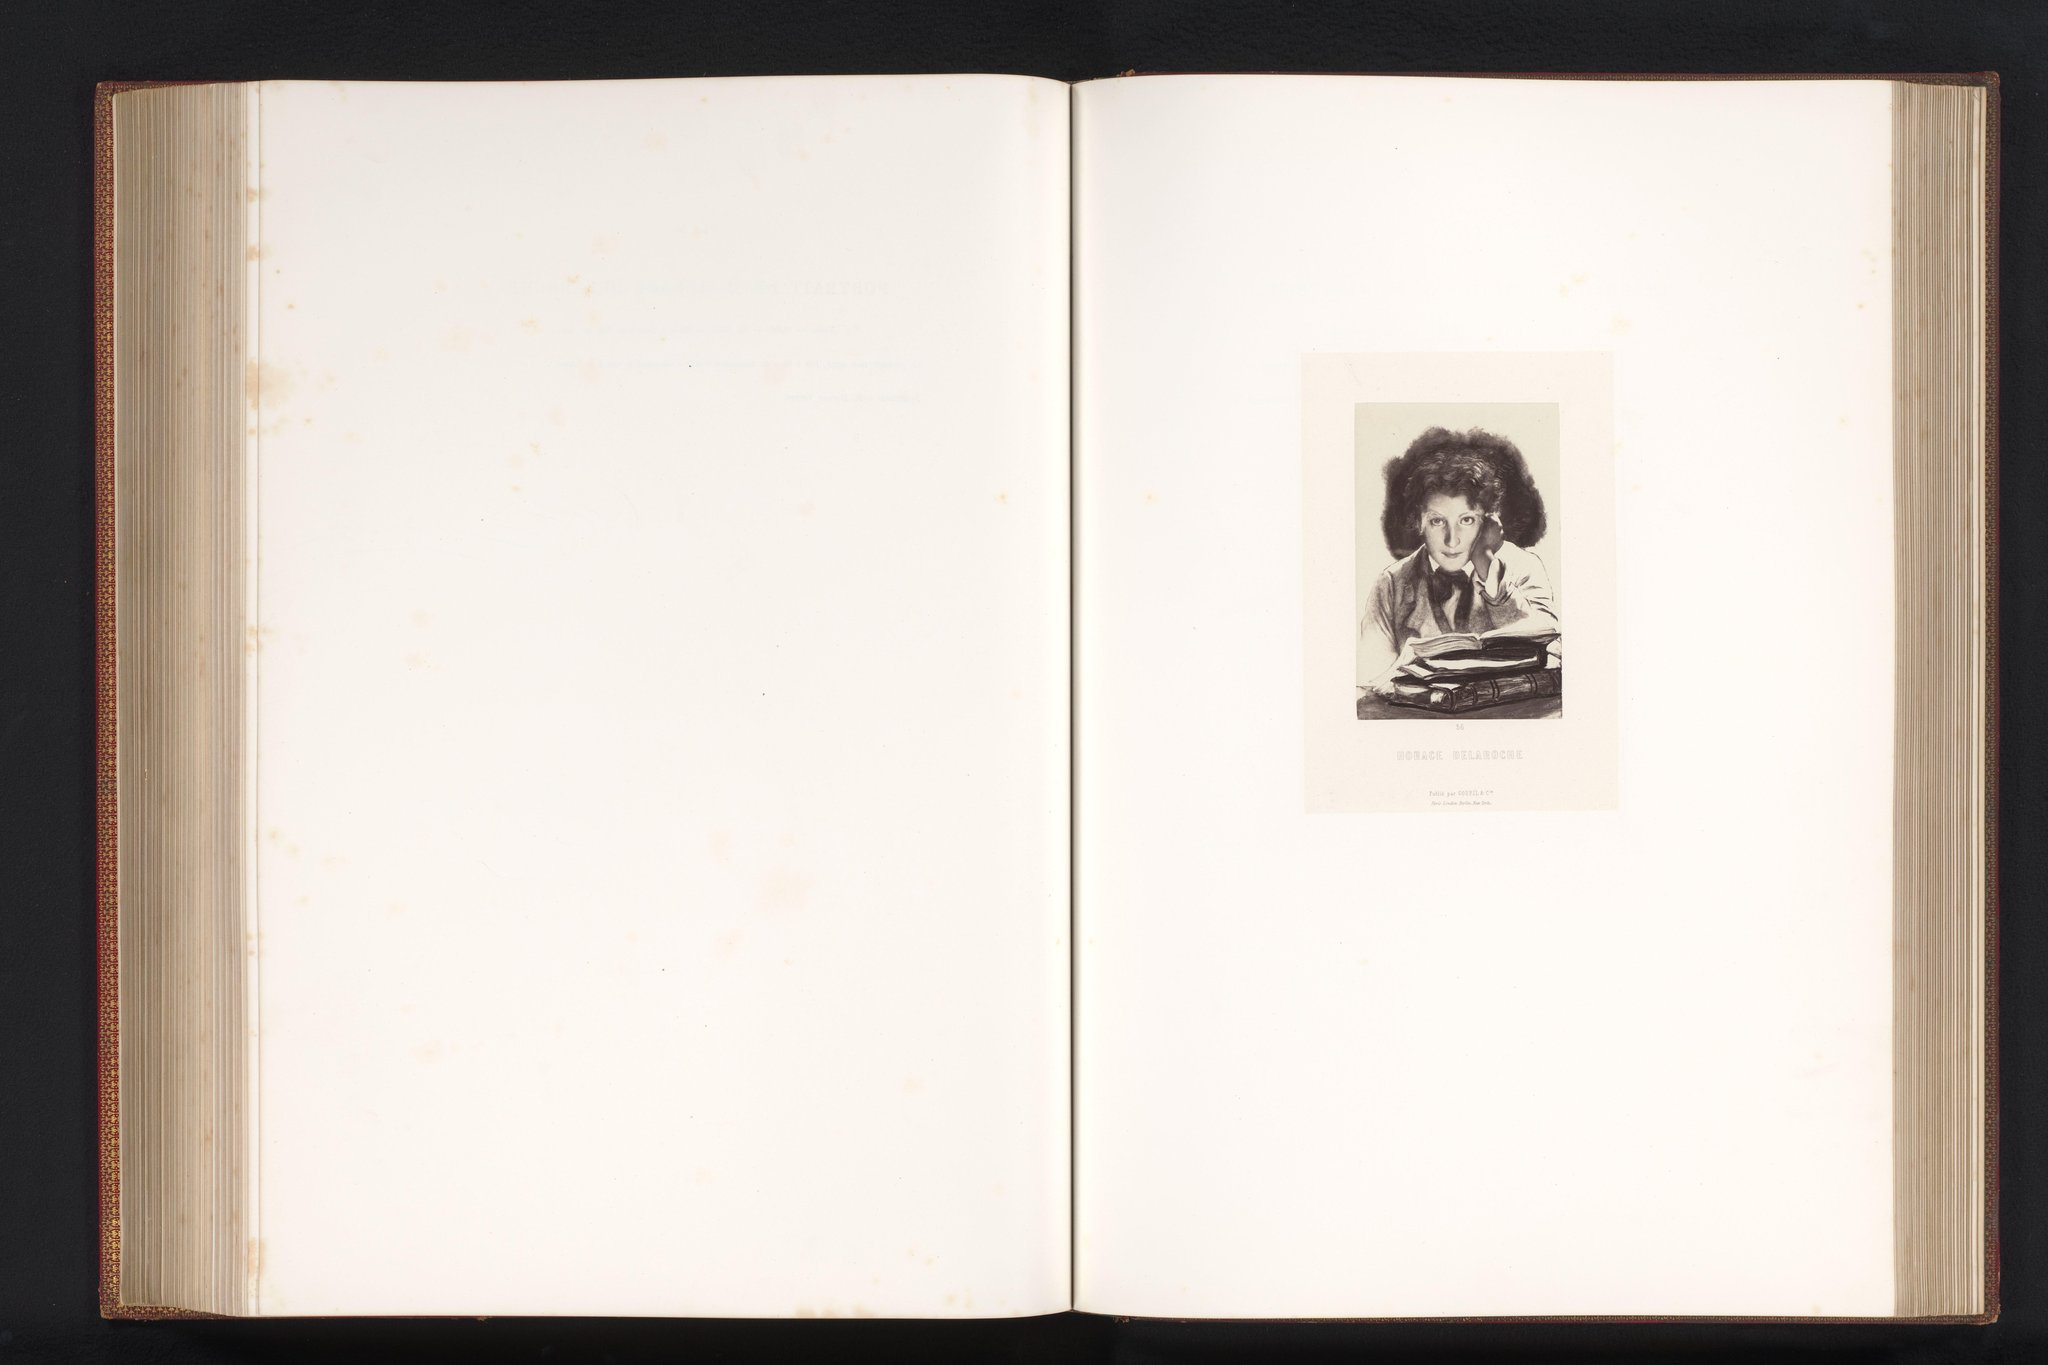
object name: photograph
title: Fotoreproductie van een geschilderd portret van Horace Delaroche, lezend, door Paul Delaroche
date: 1853-1858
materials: paper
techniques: albumen print, engraving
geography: paris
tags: reading, historical persons, youth, adolescent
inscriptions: check stamp: ‘Goupil & Cie’